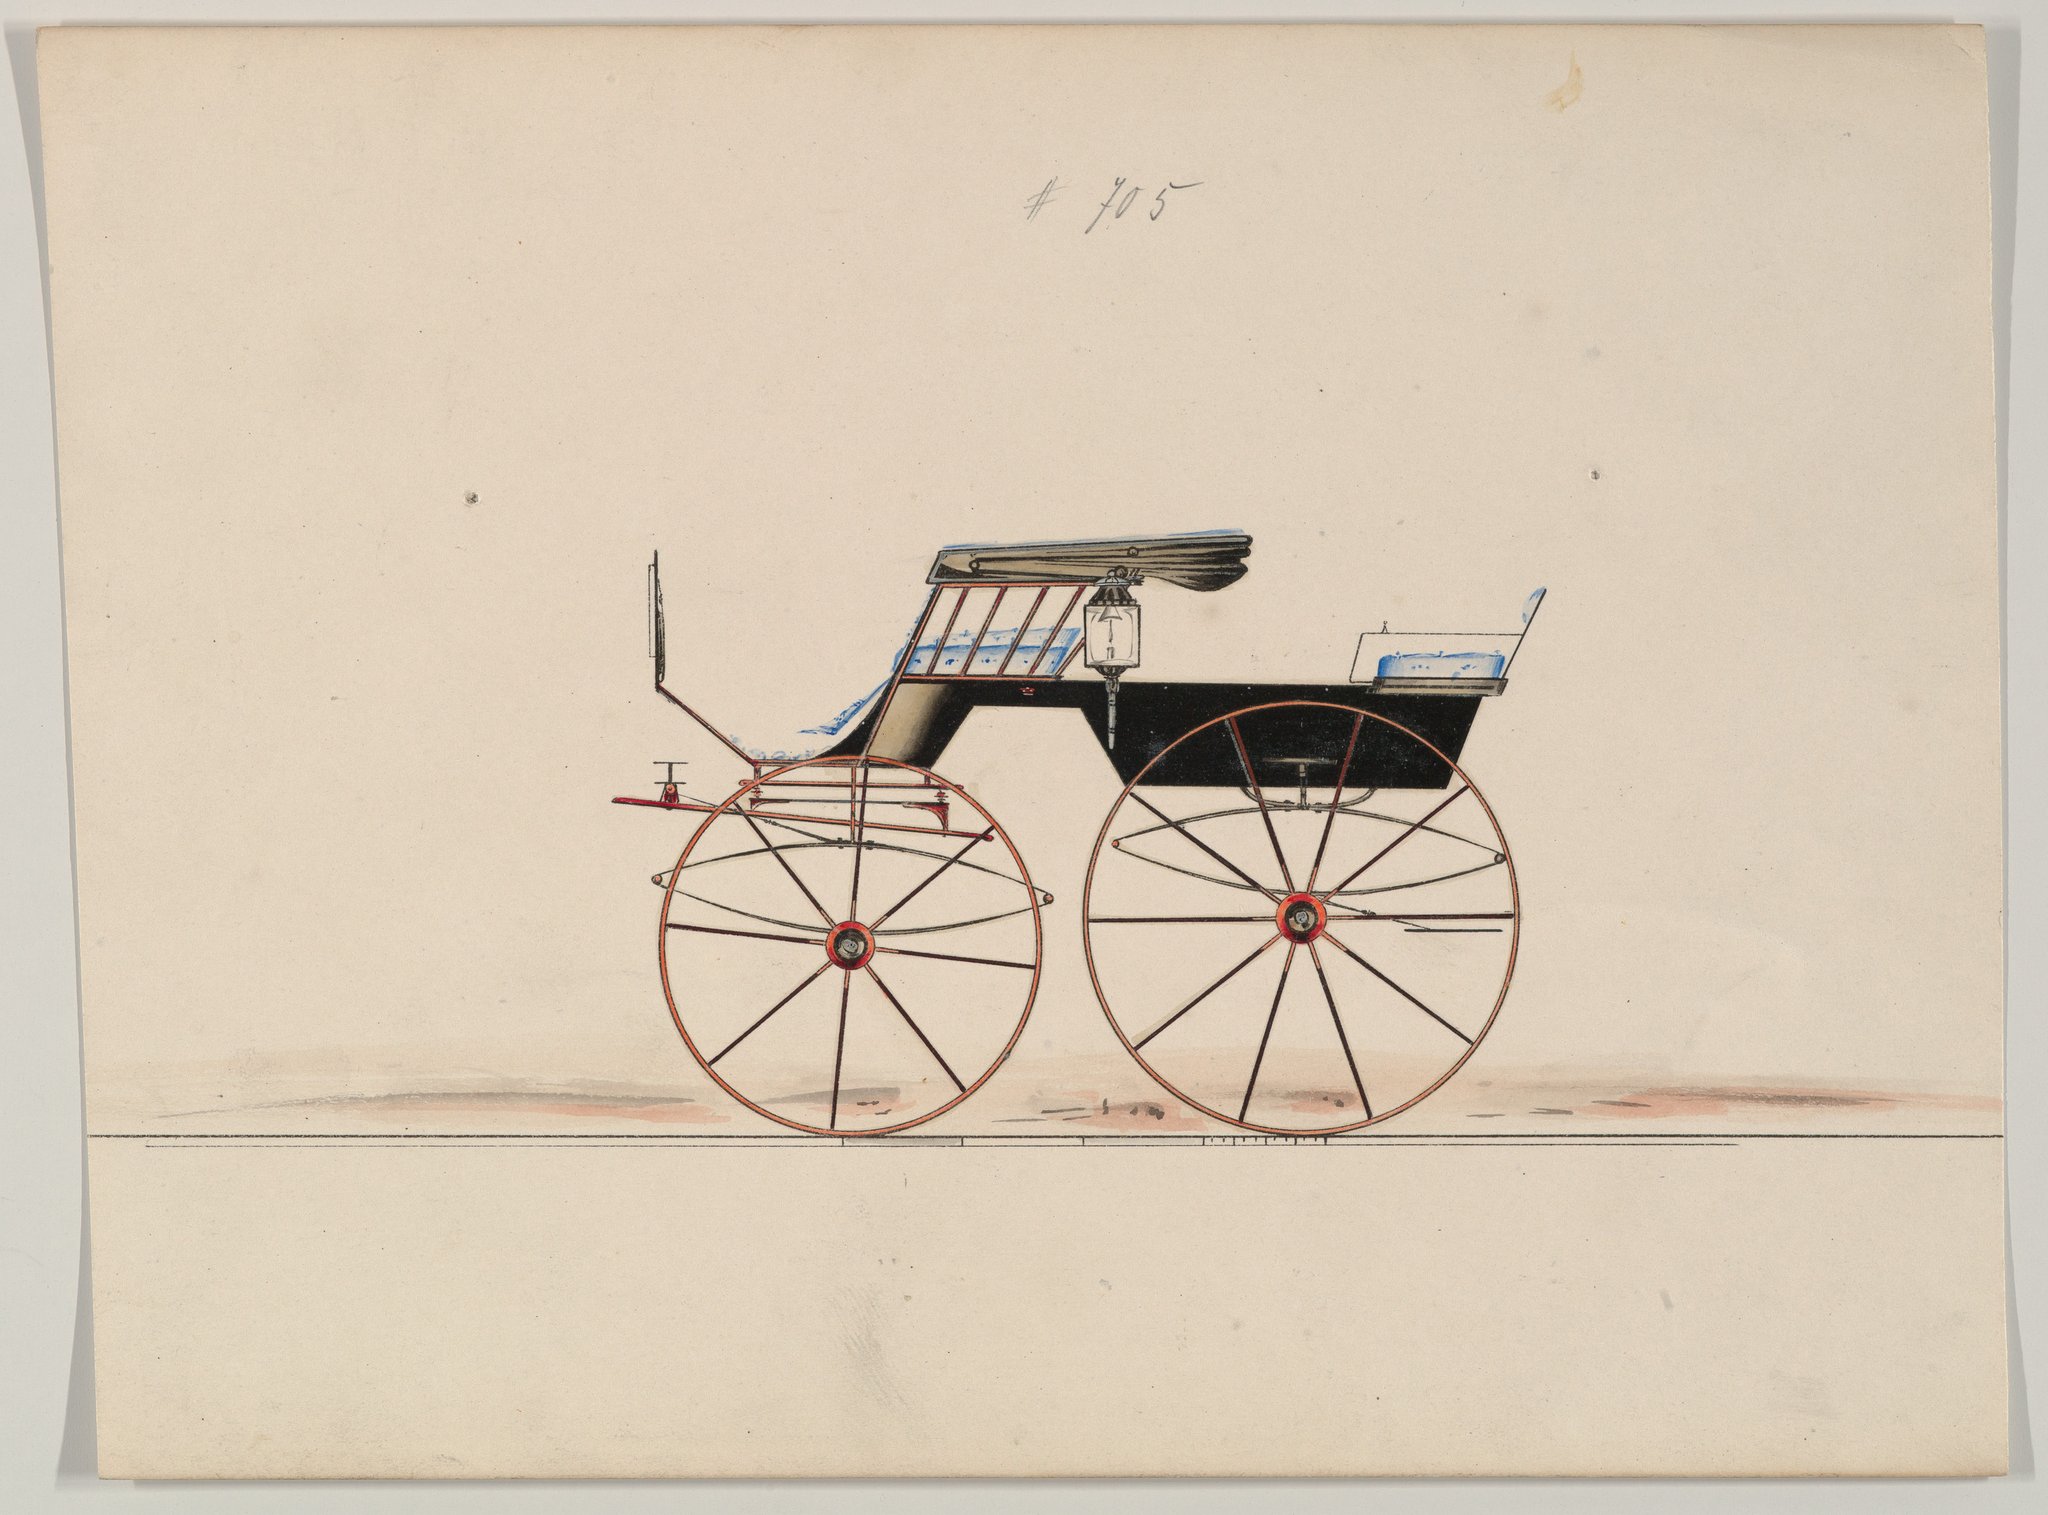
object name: drawing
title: Design for Phaeton, no. 705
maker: brewster & co.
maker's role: manufacturer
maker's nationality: american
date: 1850-1874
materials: gouache, gum arabic, ink, watercolor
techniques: pen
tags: carriages